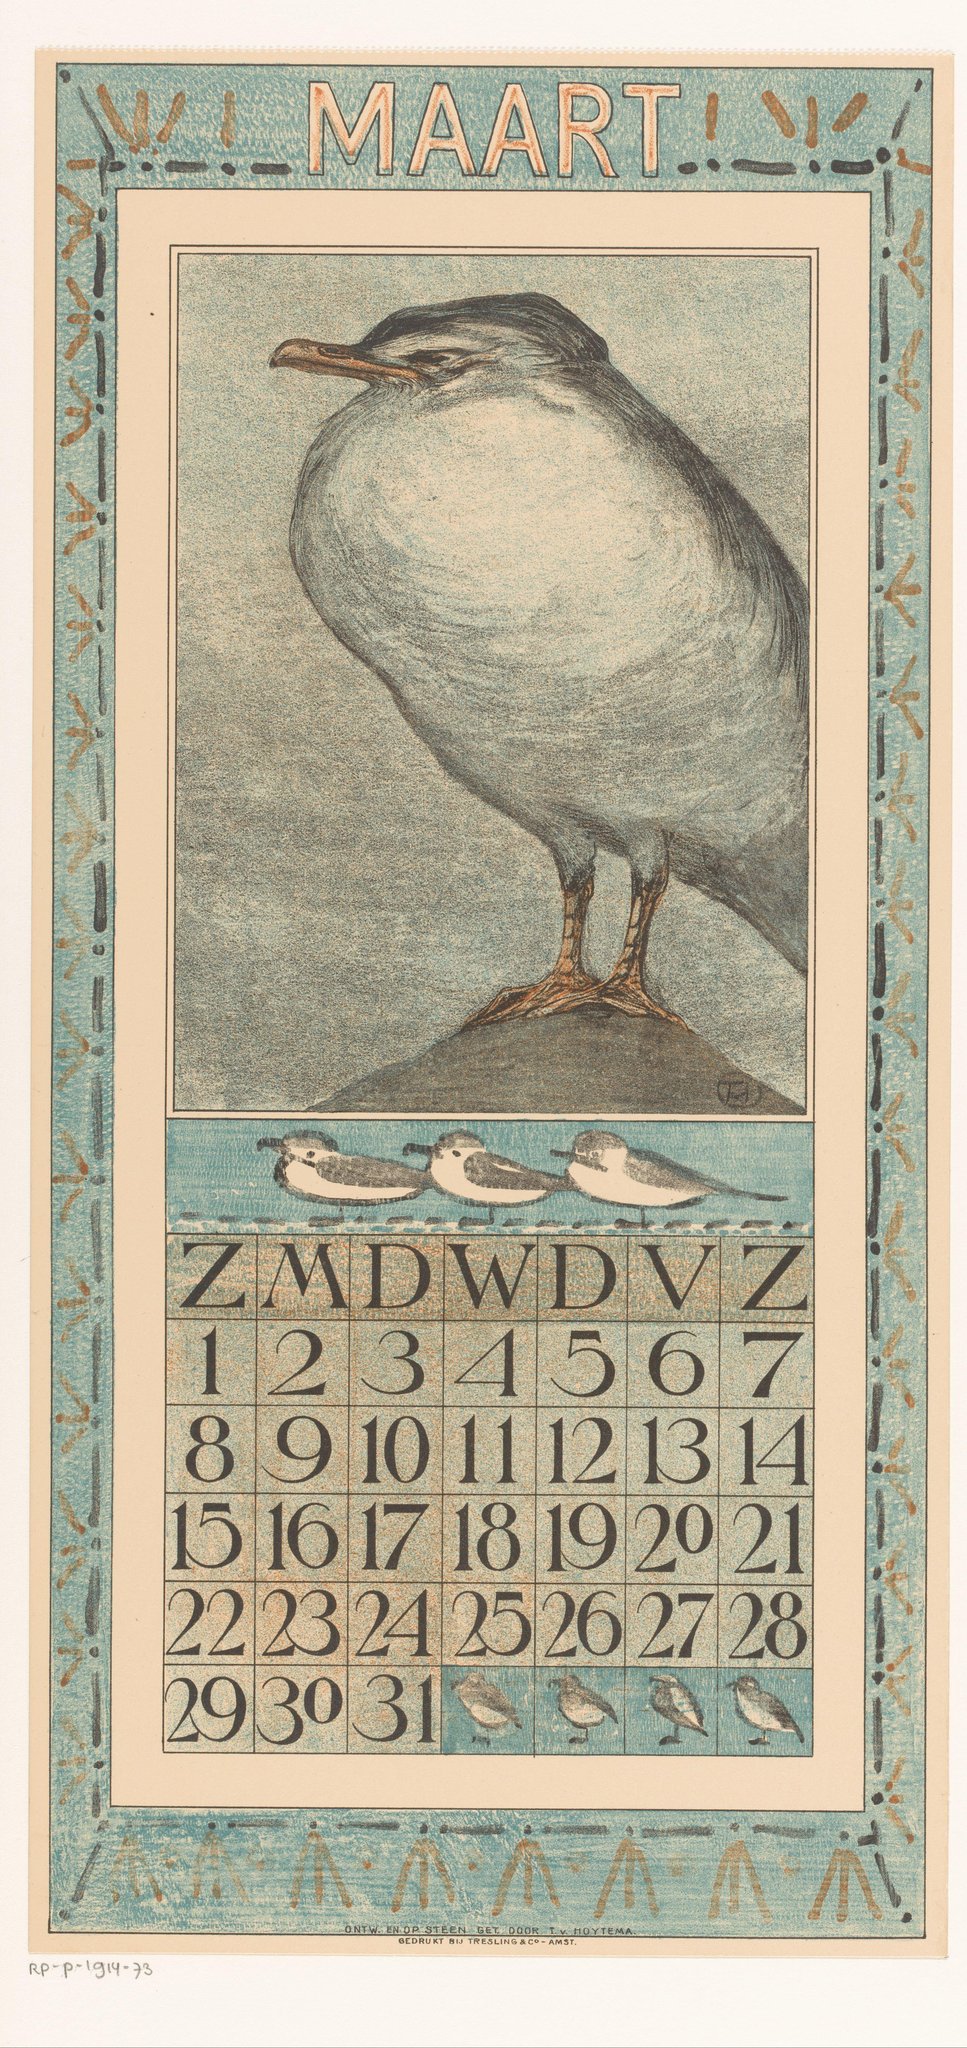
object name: calendar leaf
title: Kalender 1908 12 lithografien door Th. v. Hoytema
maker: theo van hoytema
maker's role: draughtsman, painter, print maker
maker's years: 1863-1917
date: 1907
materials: paper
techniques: lithograph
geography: amsterdam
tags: shore-birds and wading-birds: gull, march ~ other concepts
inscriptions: collector's mark: Lugt 2228